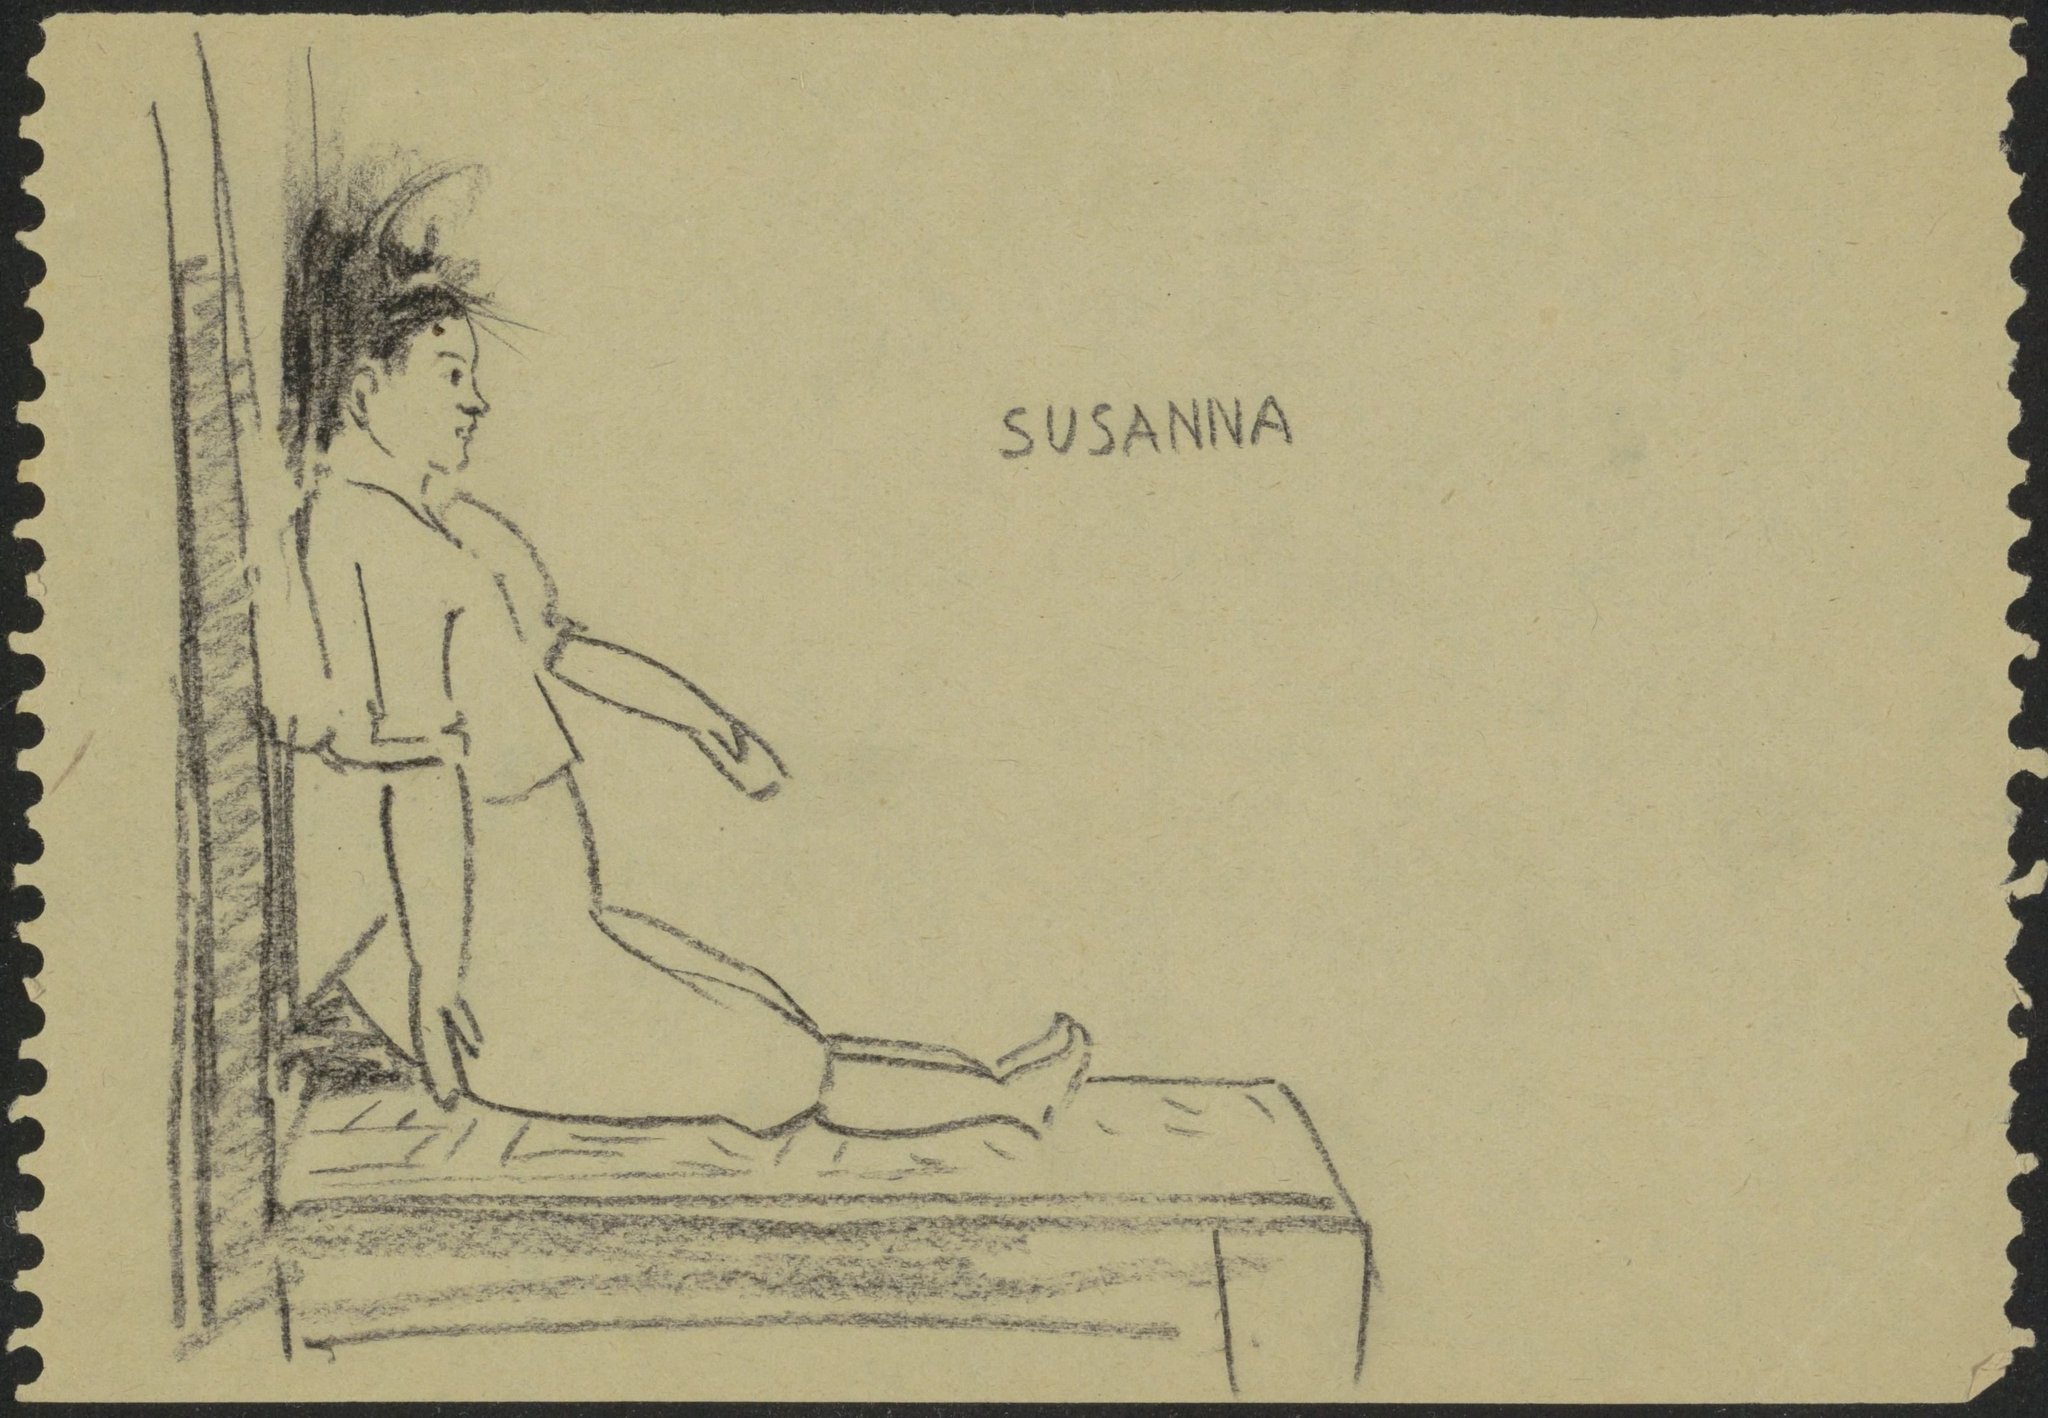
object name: drawing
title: Lappenpop Susanna zittend op een stoel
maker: gerrit willem dijsselhof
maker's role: designer, draughtsman, print maker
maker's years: 1866-1924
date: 1904-1906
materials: chalk, paper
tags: (playing with) dolls, chair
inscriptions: annotation: ‘SUSANNA’